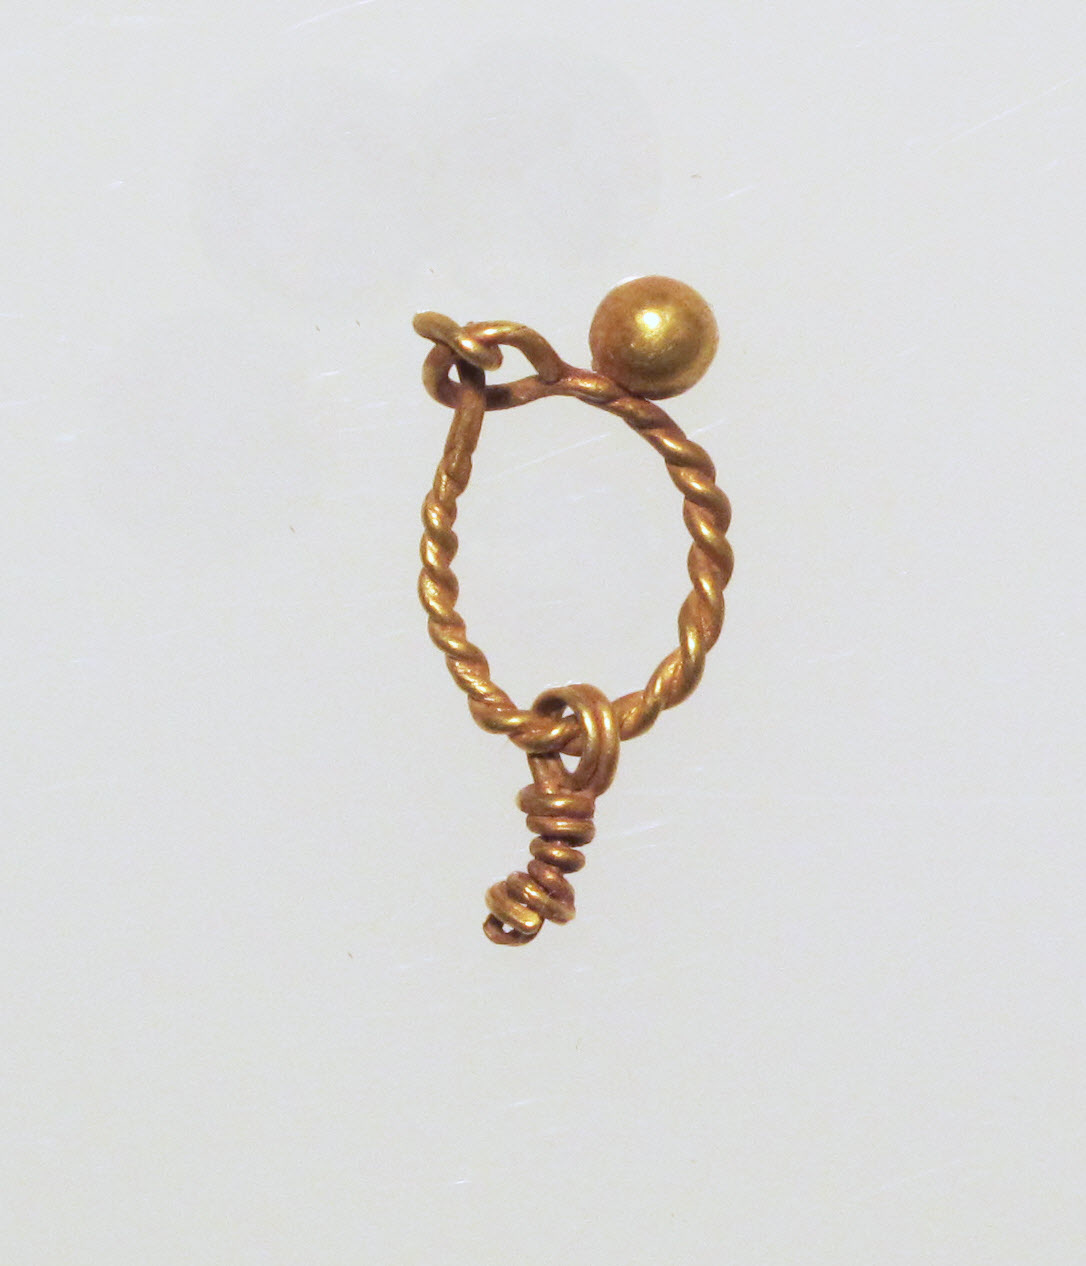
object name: earring with pendant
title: Gold earring with ball stud and pendant (missing)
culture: roman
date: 101-200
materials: gold